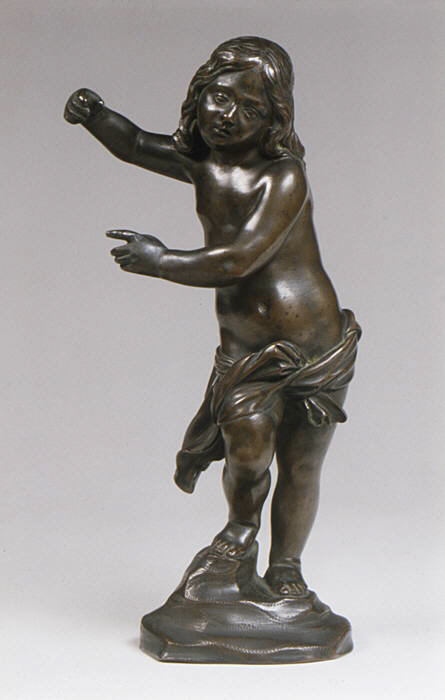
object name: statuette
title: Standing Child (Possibly a Young St. John the Baptist)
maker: ferdinando tacca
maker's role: artist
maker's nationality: italian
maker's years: 1619-1686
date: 1665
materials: bronze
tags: boys